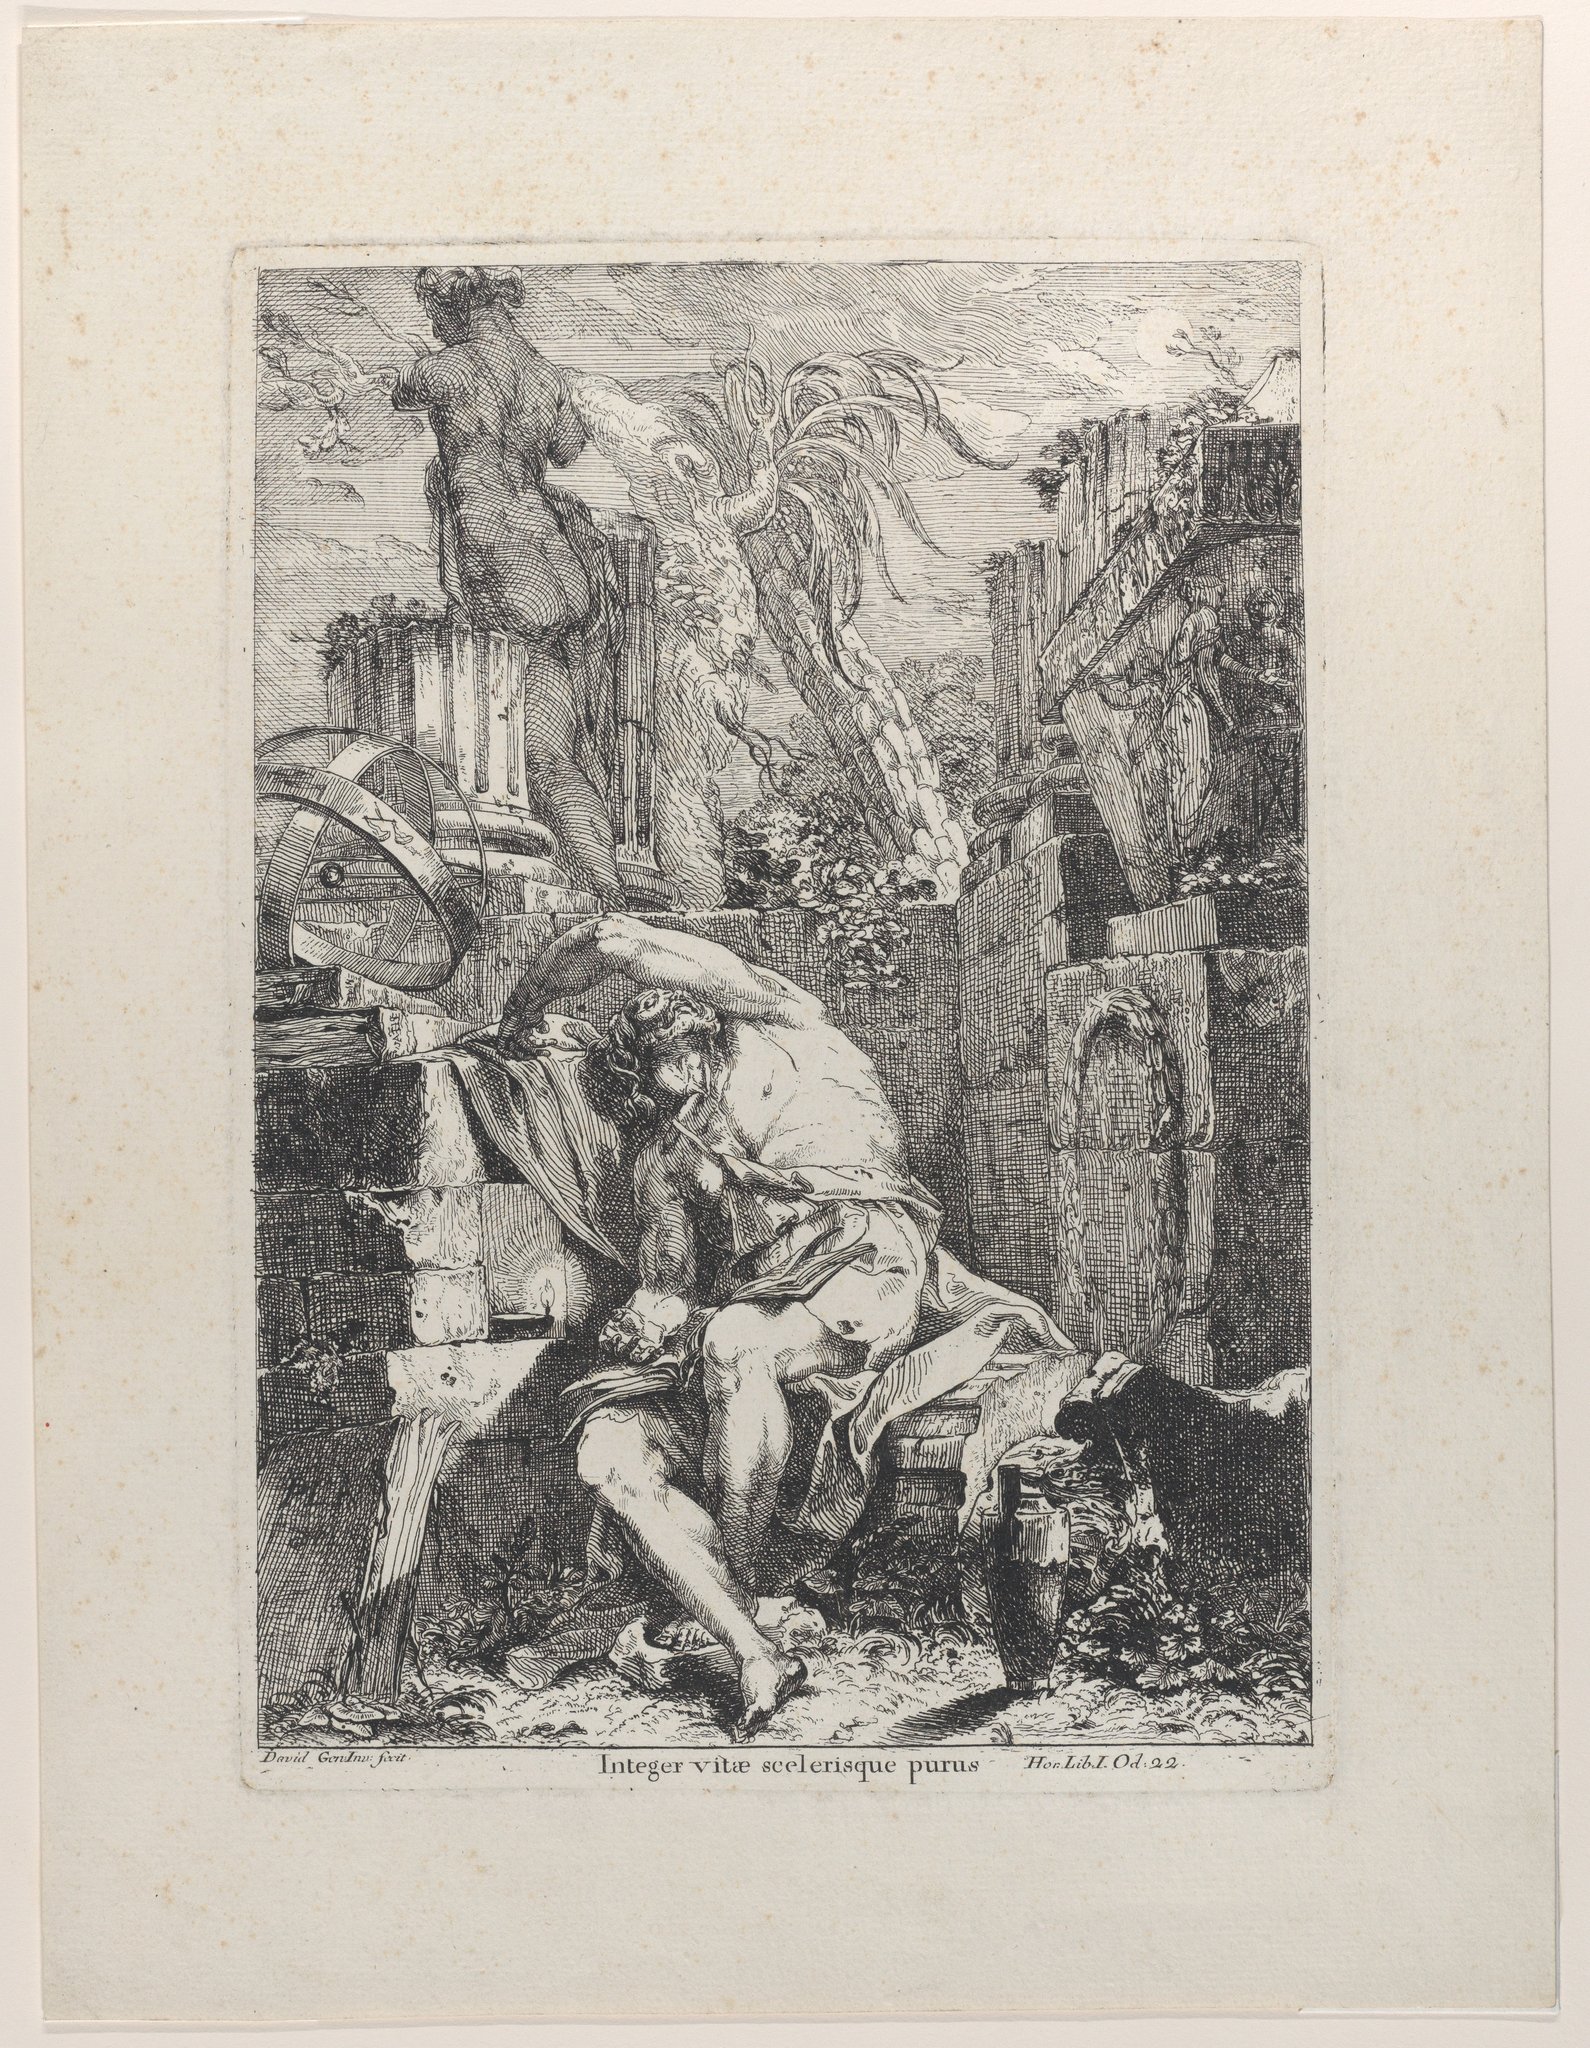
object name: print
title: The Righteous Man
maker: giovanni david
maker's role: artist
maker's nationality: italian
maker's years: 1749-1790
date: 1775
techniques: etching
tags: men